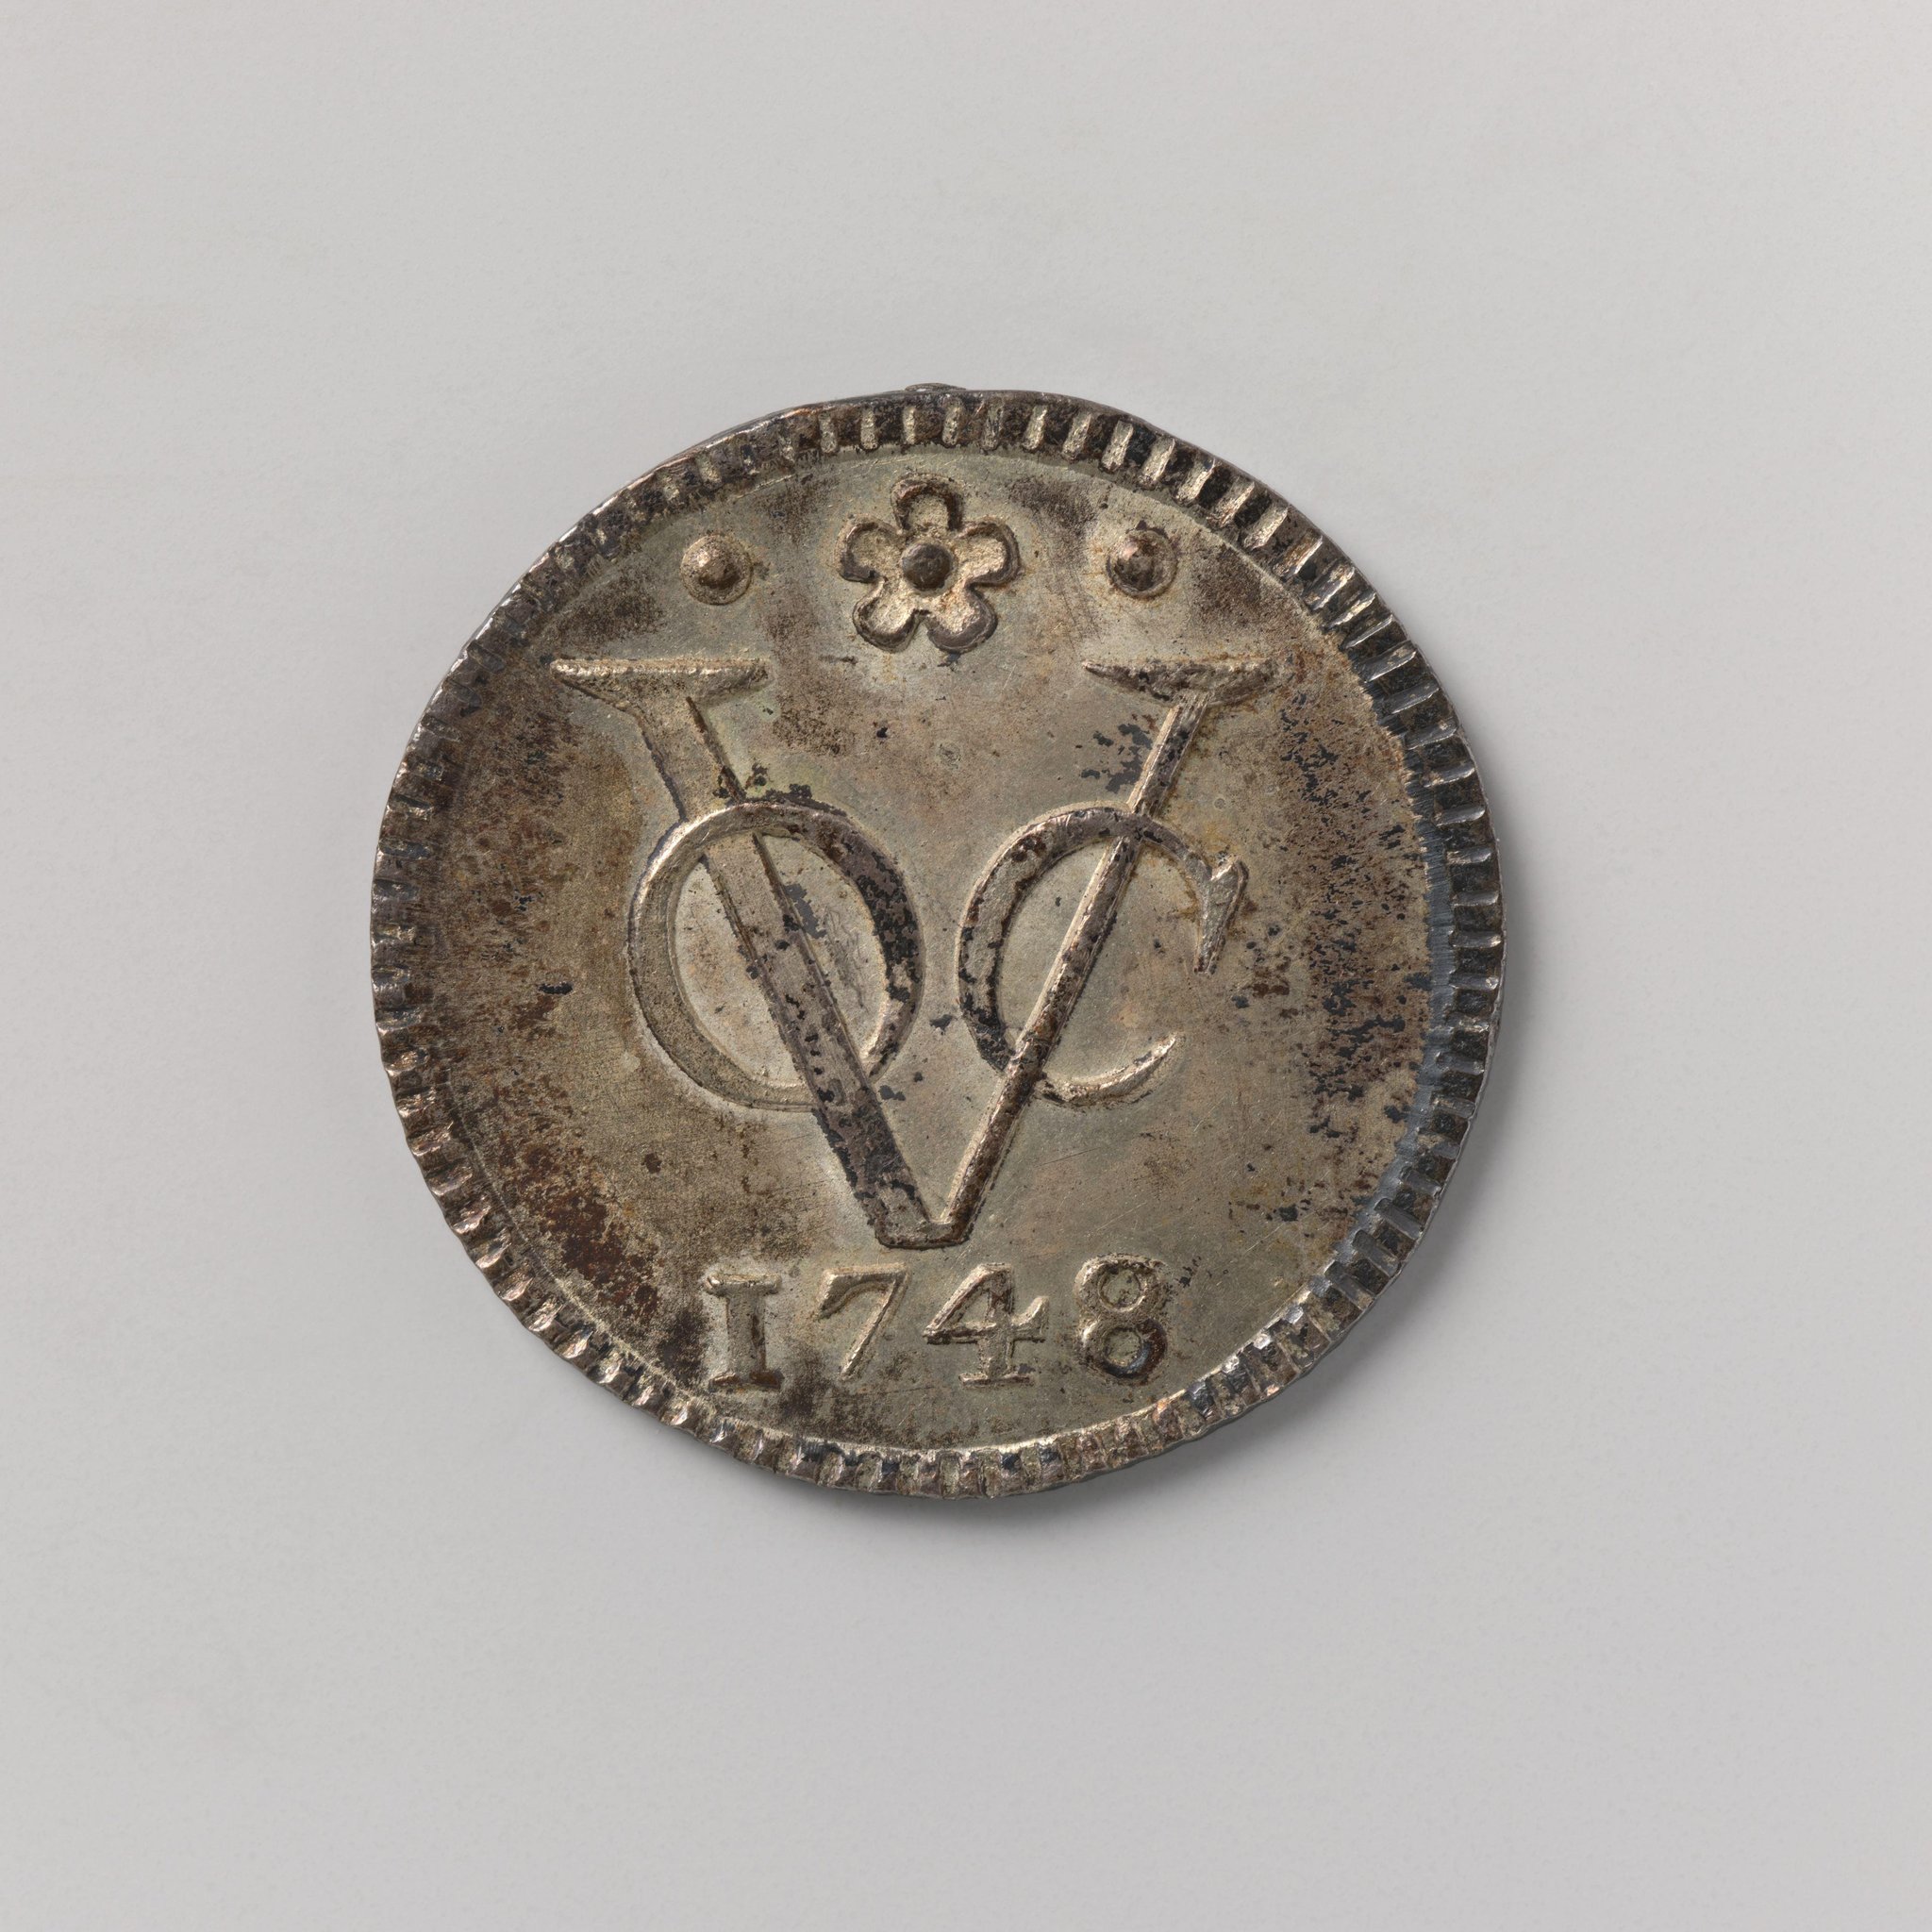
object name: coin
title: VOC, duit Holland, 1748. Afslag in zilver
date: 1748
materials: silver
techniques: striking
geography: dordrecht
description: Zilveren munt. Voorzijde: gekroond wapenschild van Holland. Keerzijde: monogram van de VOC, waarboven muntteken en waaronder jaartal. Gladde rand. Afslag in zilver.